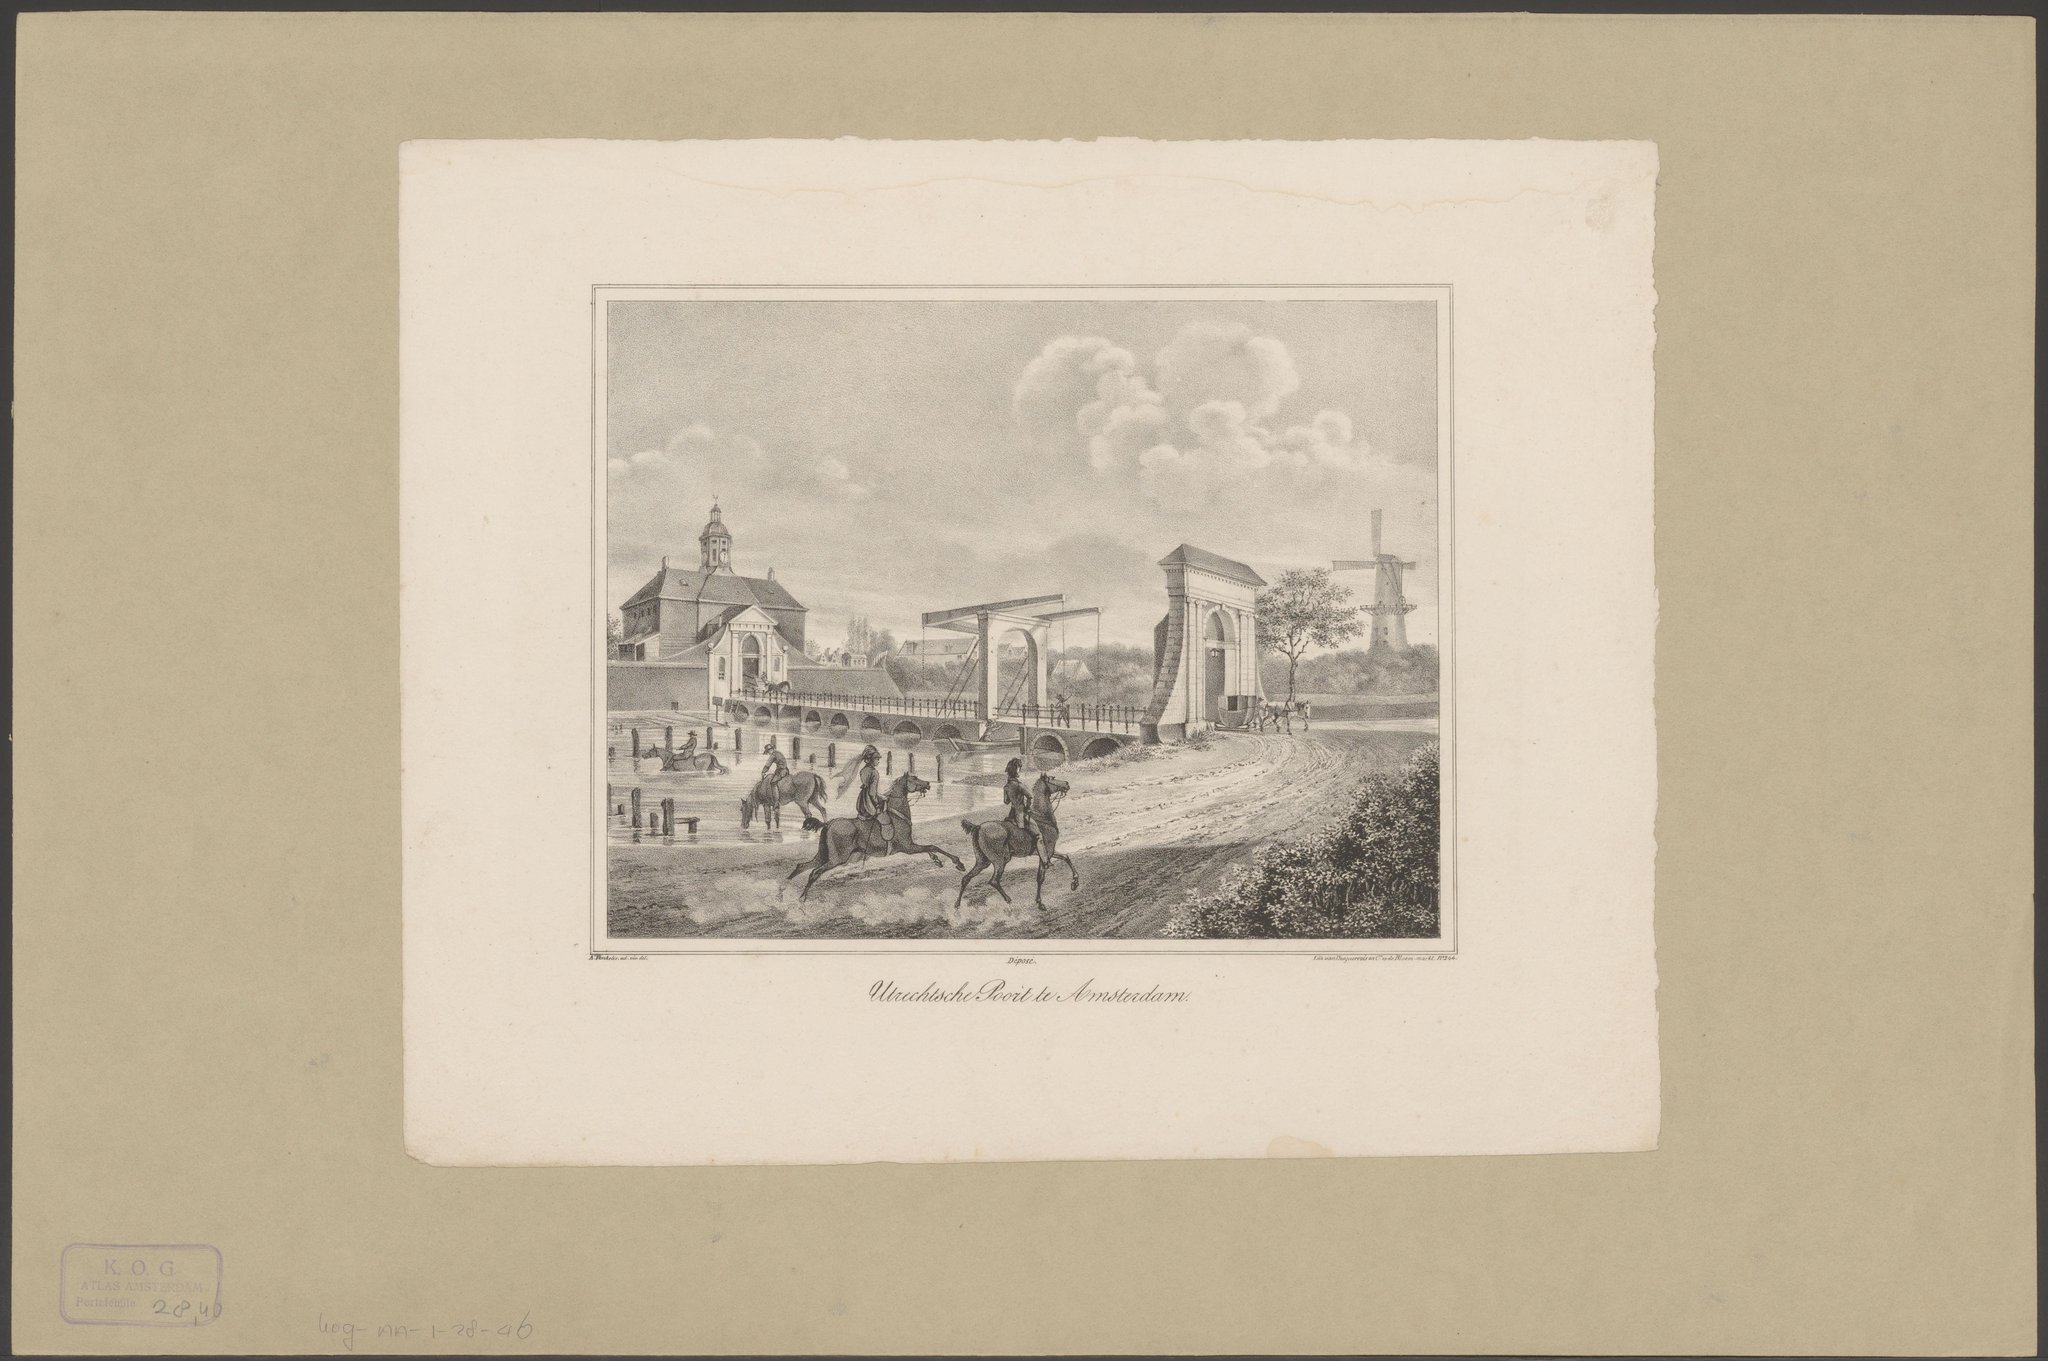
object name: print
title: Utrechtse Poort te Amsterdam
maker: abraham vinkeles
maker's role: draughtsman, print maker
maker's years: 1790-1864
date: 1828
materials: paper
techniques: lithograph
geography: amsterdam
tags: horse, city-gate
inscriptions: collector's mark: Lugt 1641b, : ‘Déposé’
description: Mogelijk gepubliceerd als onderdeel van een omslag met een serie van zes lithografieën van Amsterdamse poorten.